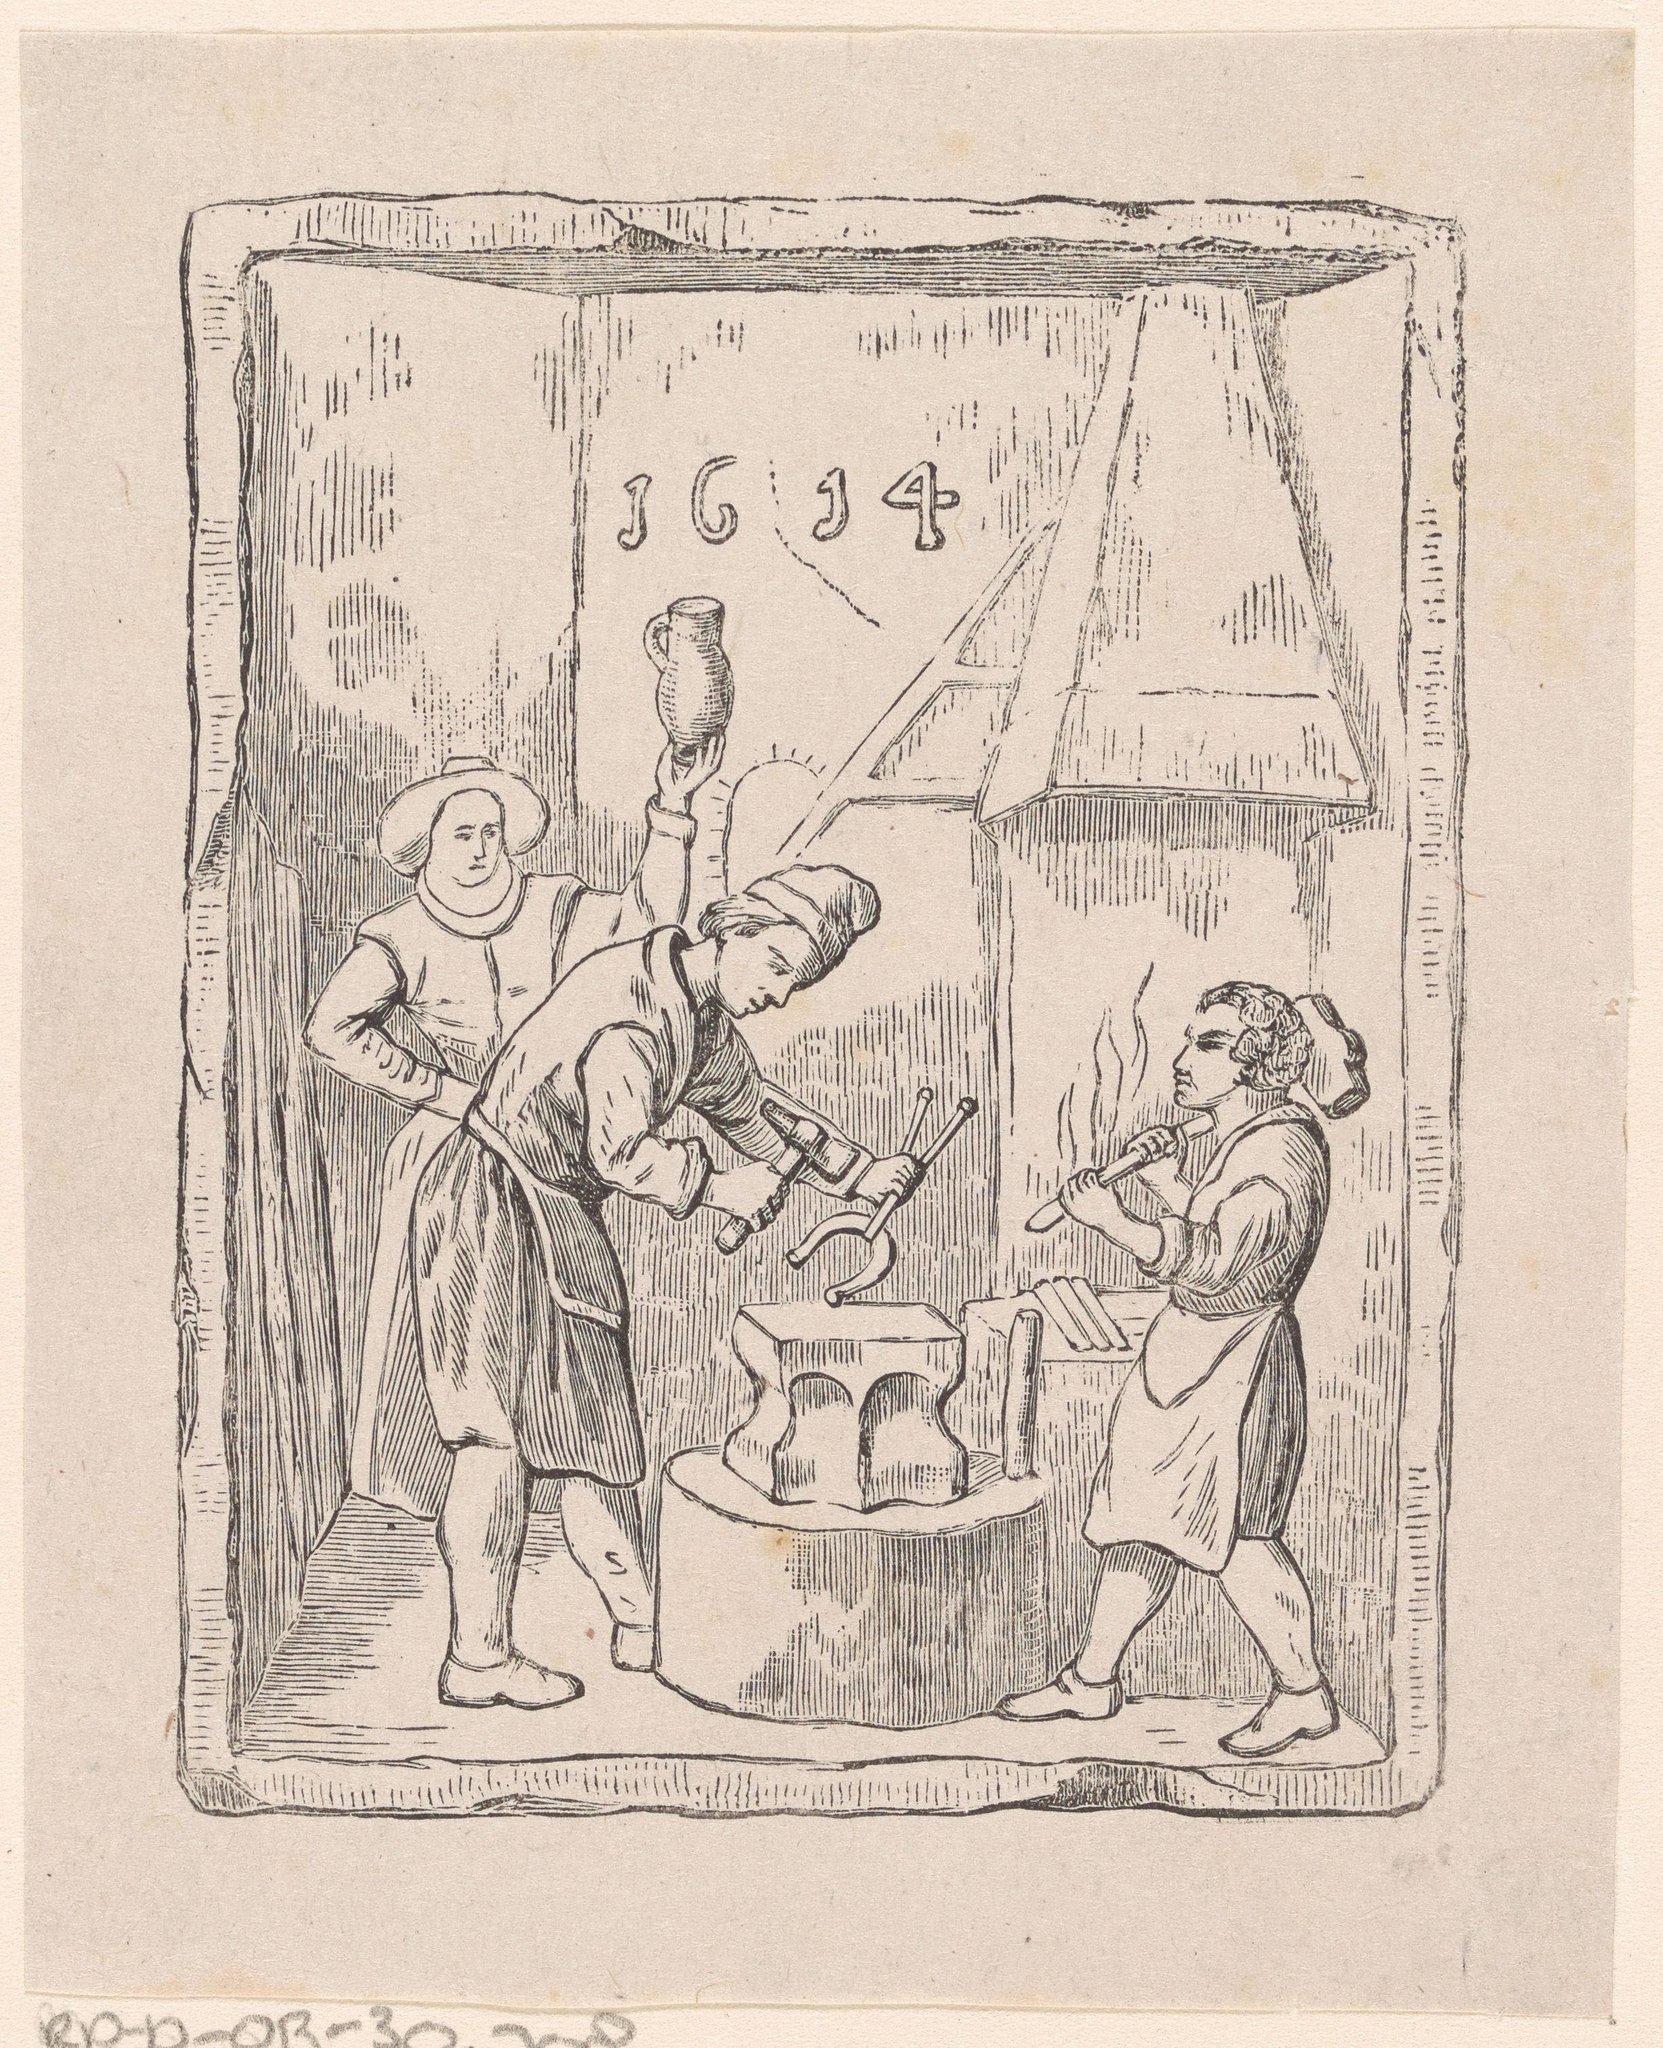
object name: print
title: Gedenksteen met daarop drie hoefsmeden en het jaartal '1614'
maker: isaac weissenbruch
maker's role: print maker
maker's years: 1826-1912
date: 1836-1912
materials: paper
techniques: engraving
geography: netherlands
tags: clay tablet, stone tablet, farrier, shoeing-smith